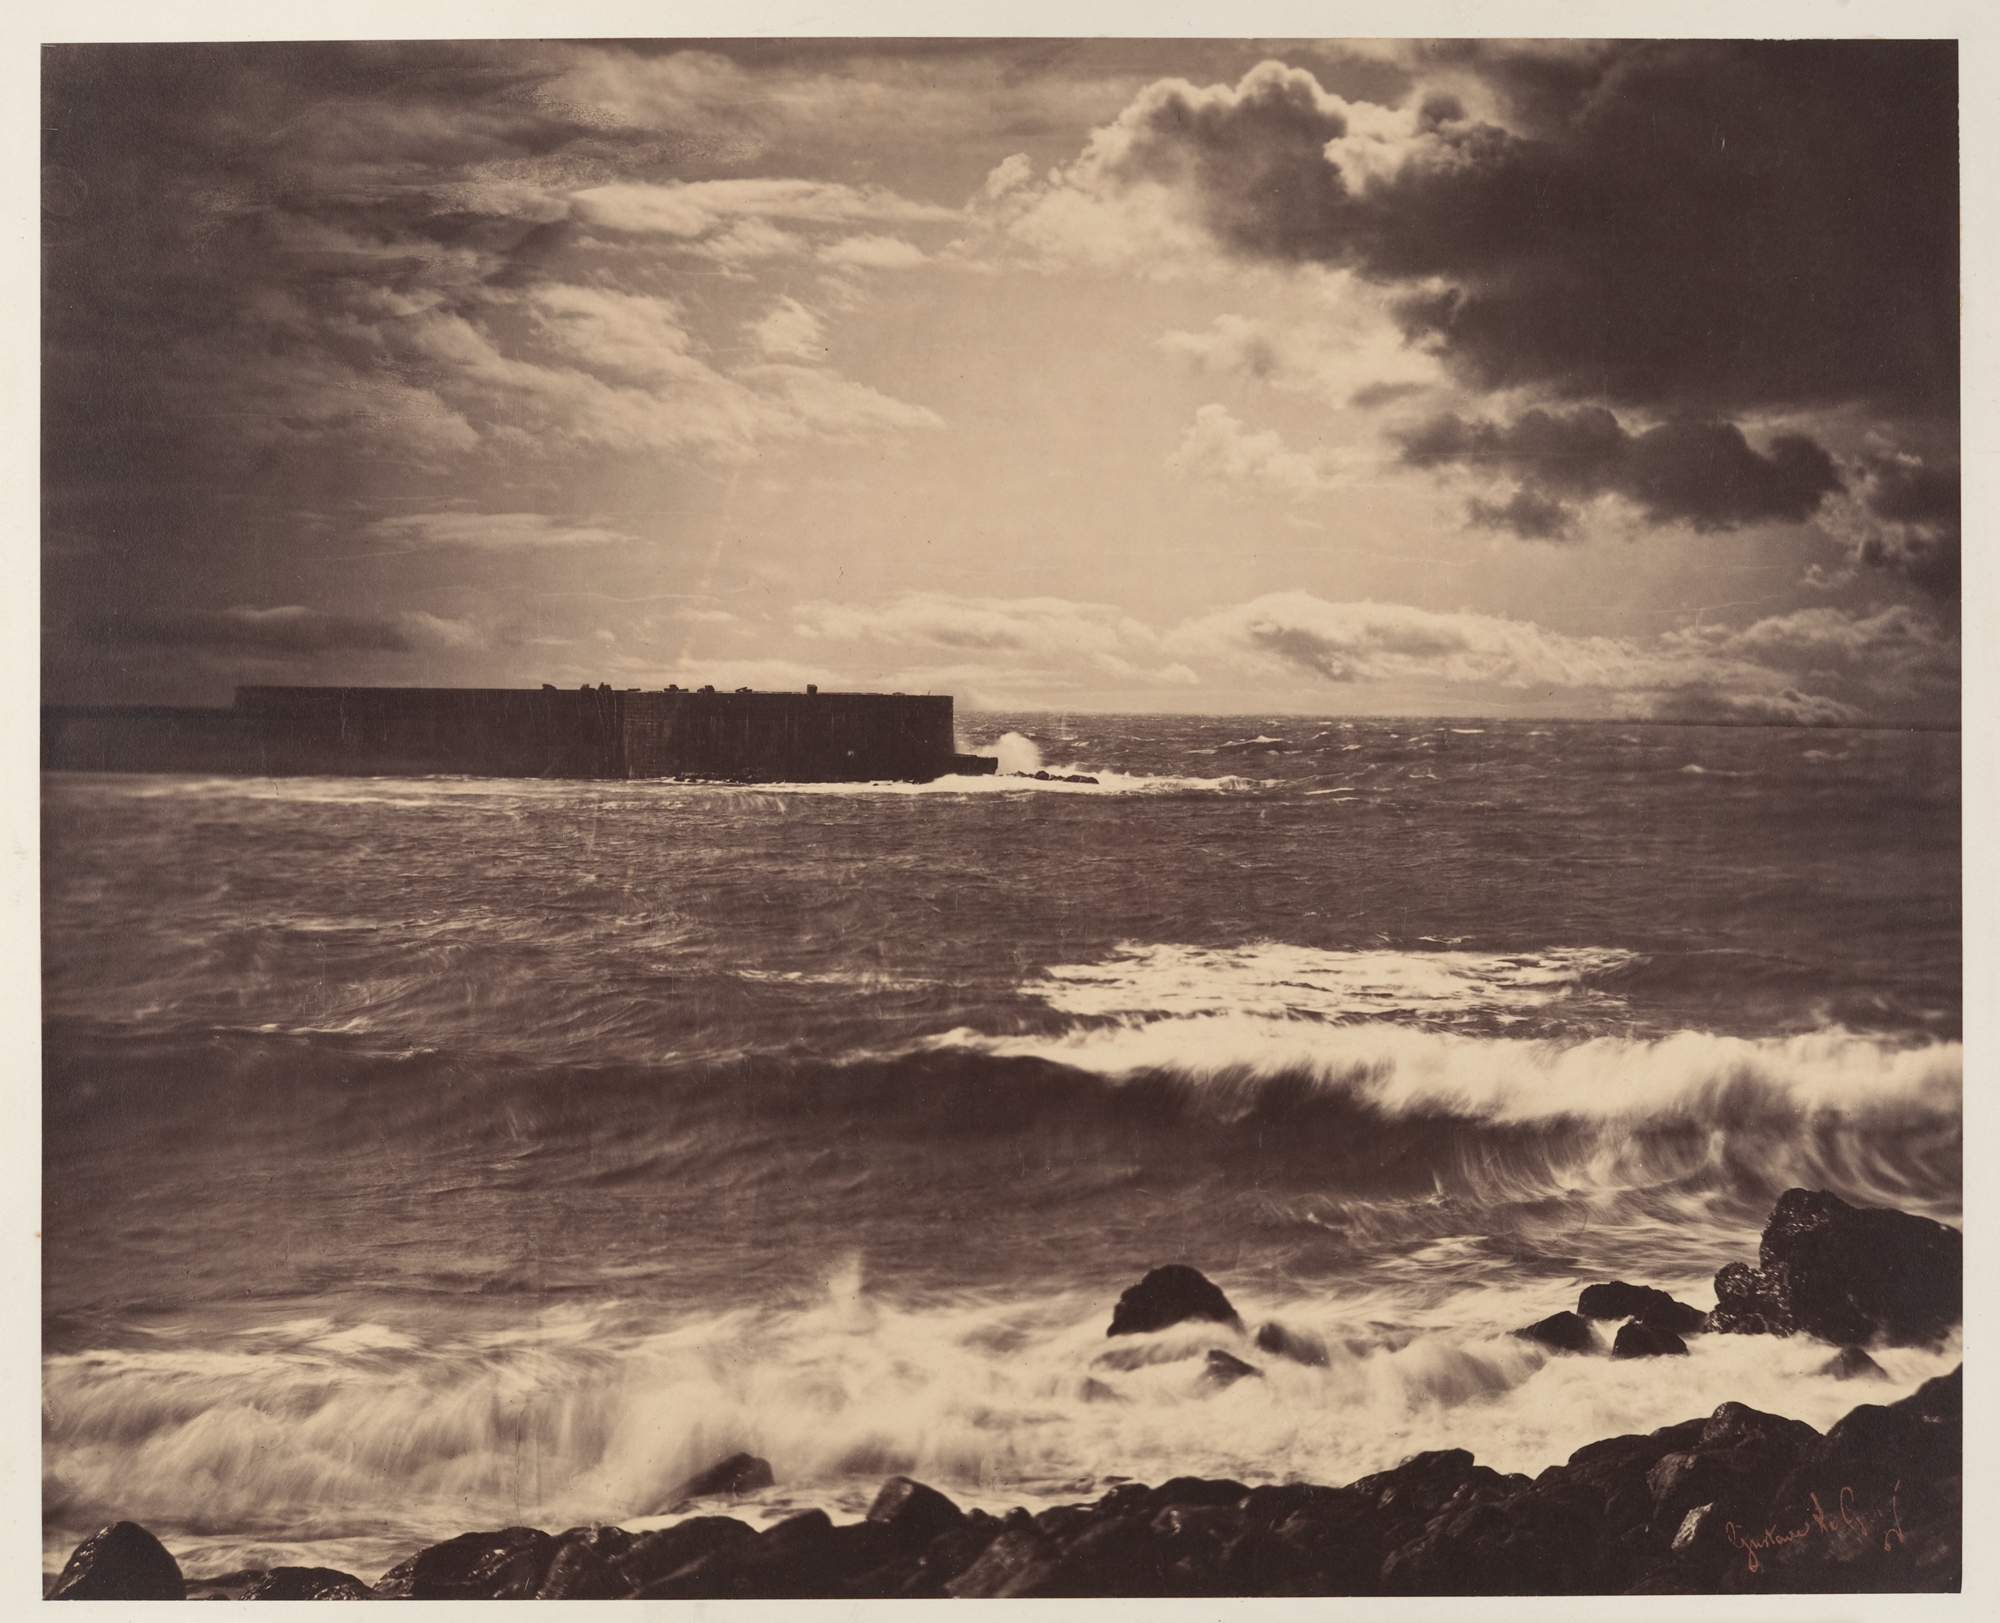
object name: photograph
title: [The Great Wave, Sète]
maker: gustave le gray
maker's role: artist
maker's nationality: french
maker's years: 1820-1884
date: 1857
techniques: albumen silver print, glass negative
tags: seascapes,waves